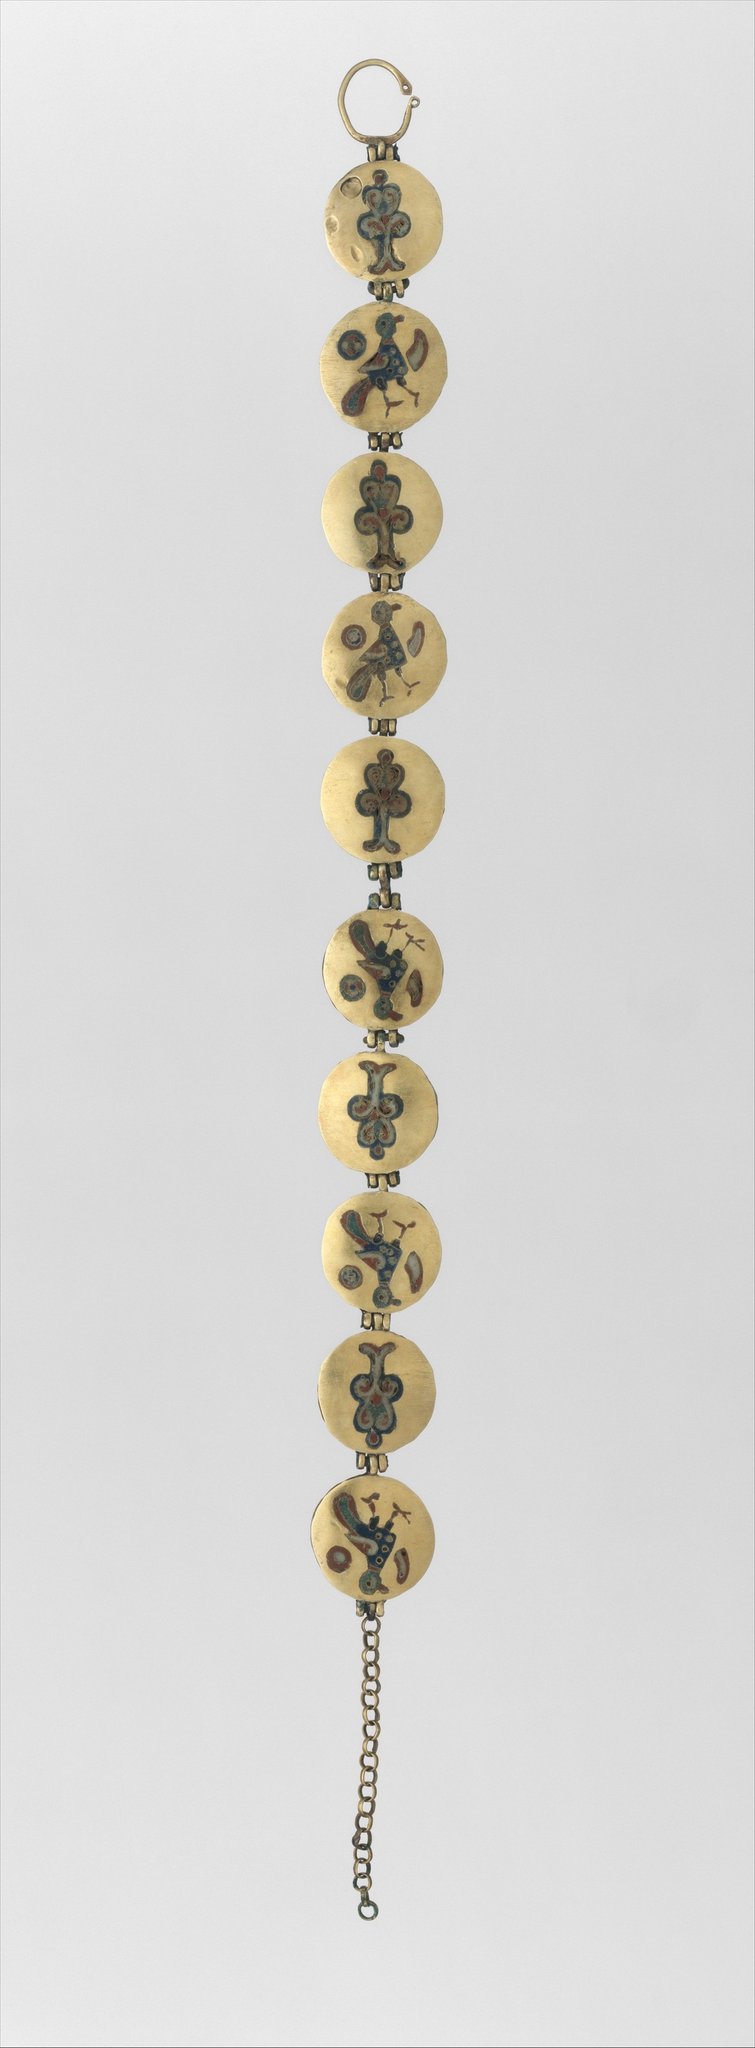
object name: dress ornament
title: Chain with Birds and Trees of Life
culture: kyivan rus’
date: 1000-1200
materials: enamel, gold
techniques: enamel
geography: ukraine